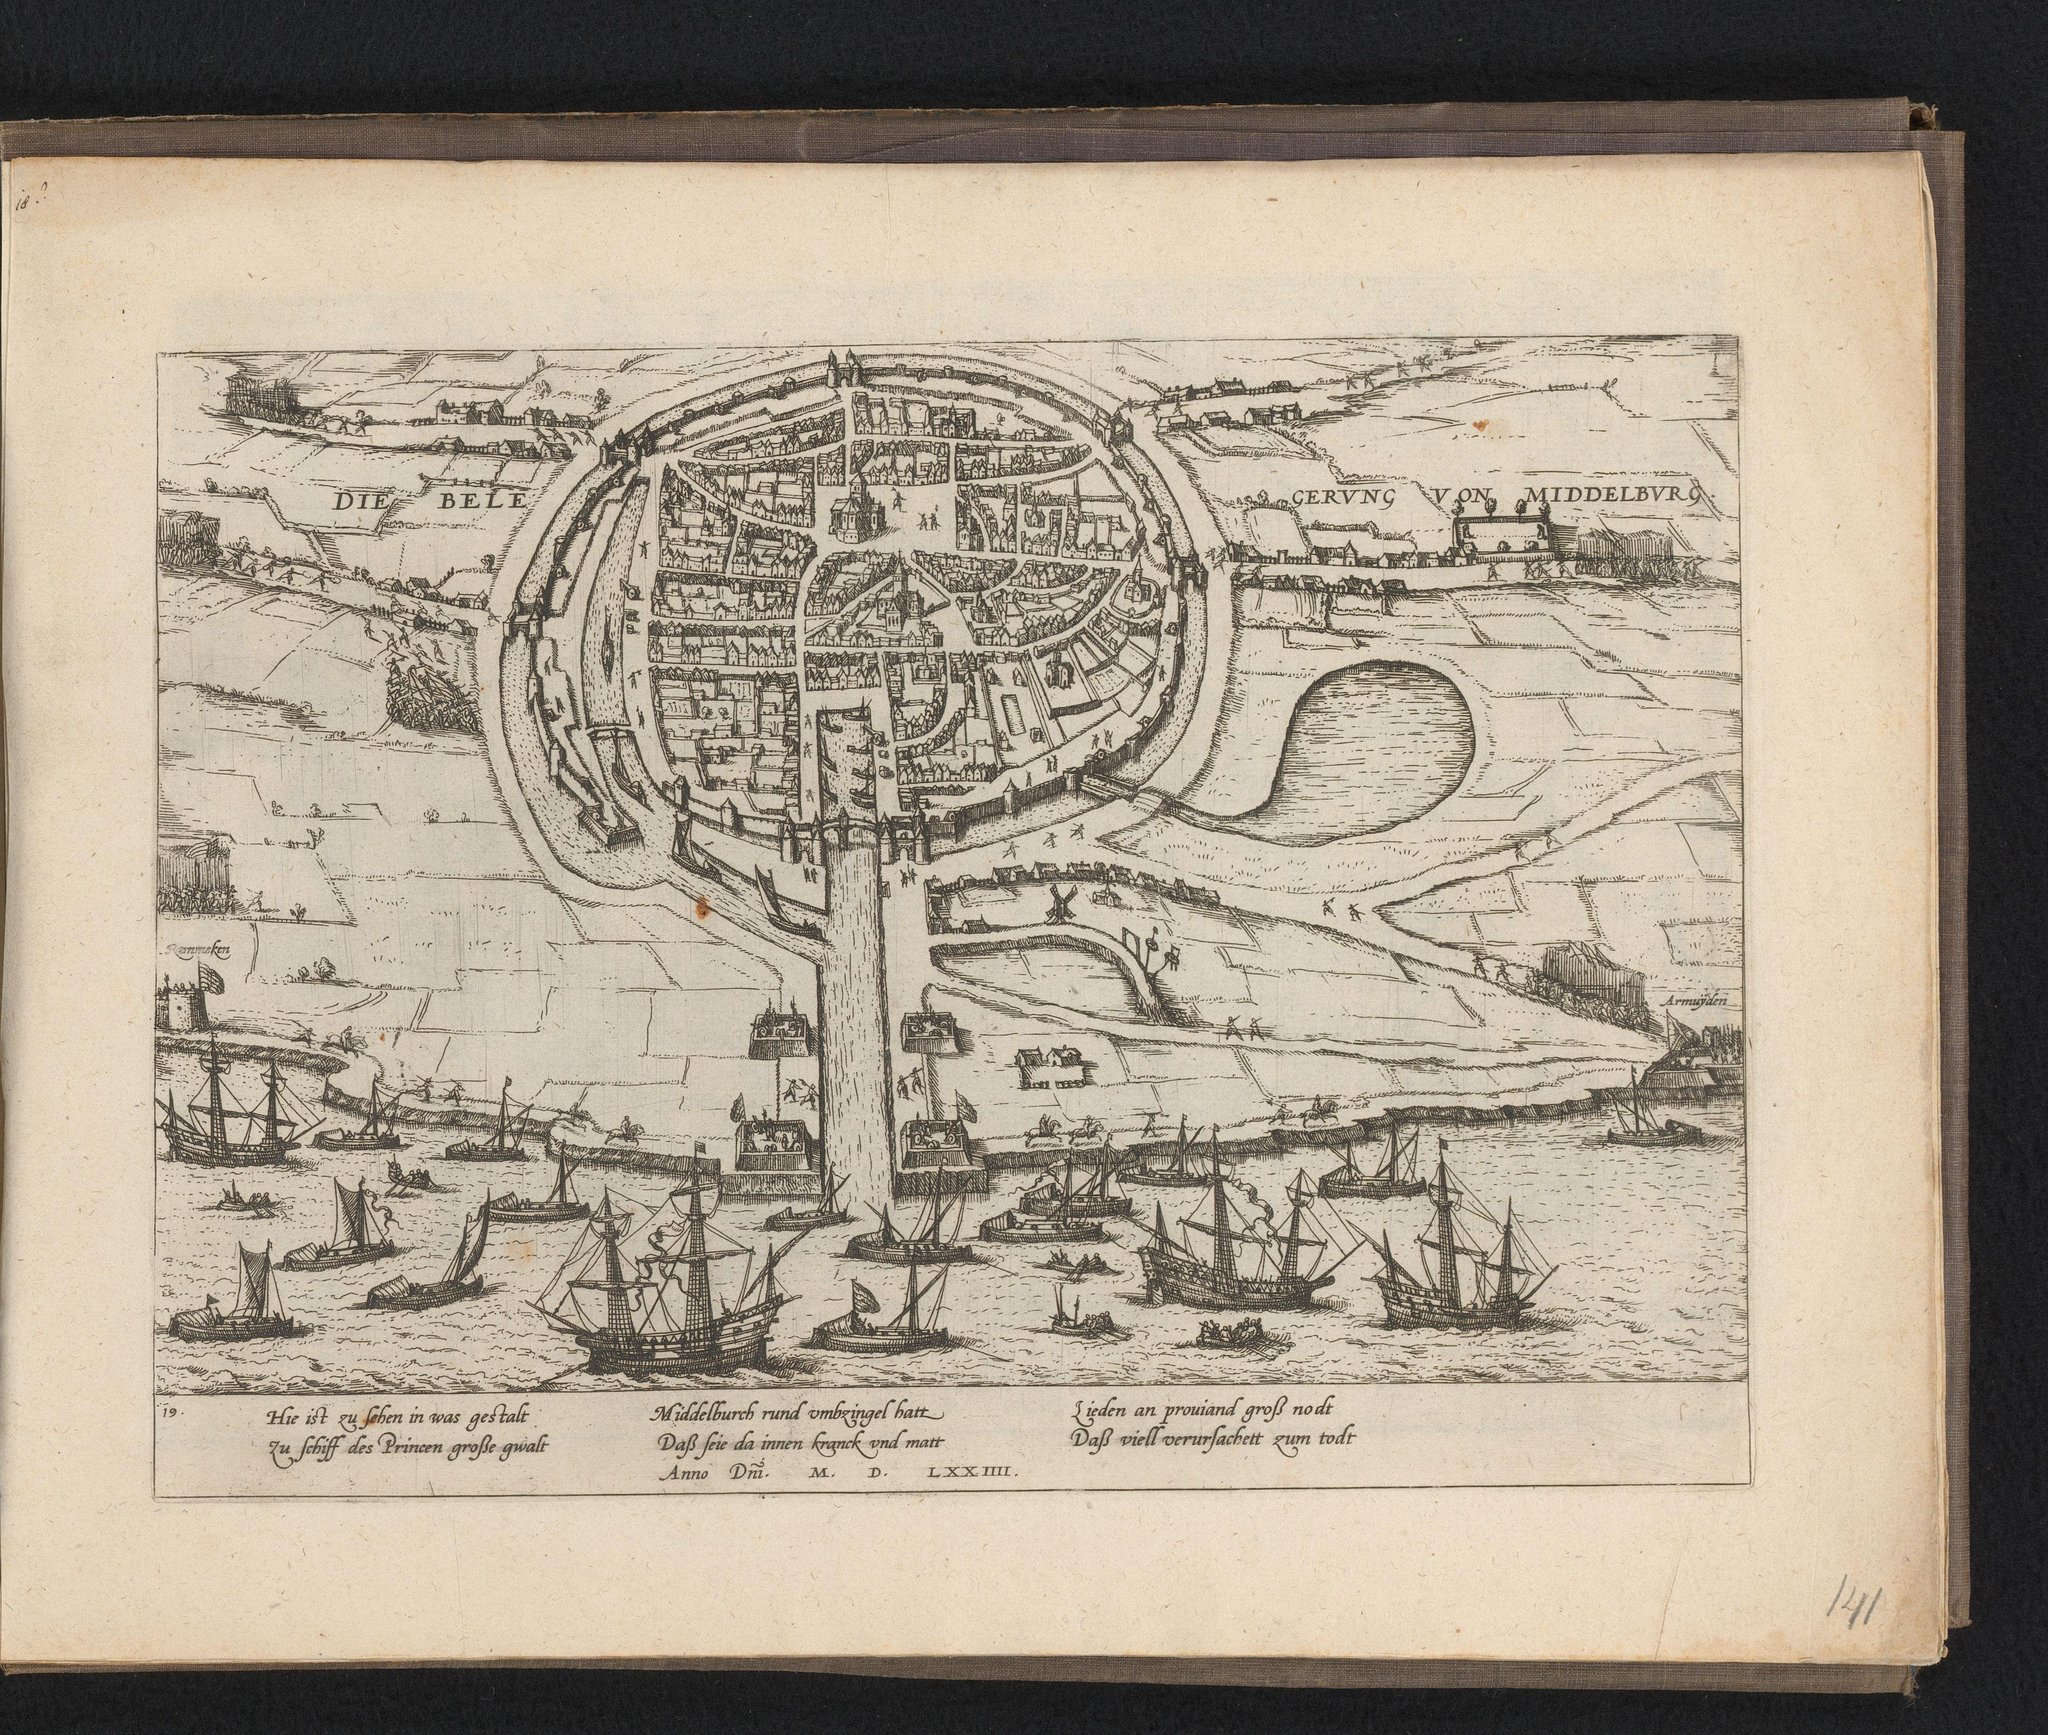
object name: album leaf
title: Folge 6: Niederländische Ereignisse der Jahre 1571-1576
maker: frans hogenberg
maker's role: print maker, publisher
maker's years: 1538-1590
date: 1574-1583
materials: paper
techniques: etching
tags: siege, position war, middelburg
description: Prent gebruikt in: Aitsinger, Michael. De Leone Belgico ejusque topographica atque historica descriptione liber (...). S.l.s.n., 1583.